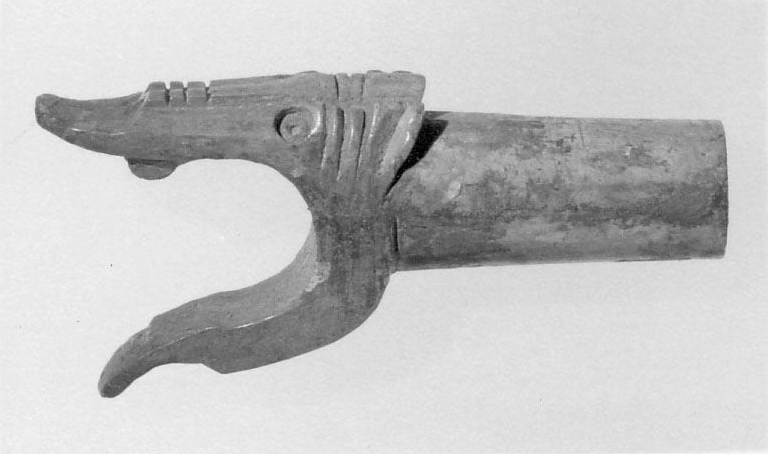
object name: finial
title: Dragon-Head Finial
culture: chinese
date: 206 BCE-9 CE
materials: bone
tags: dragons